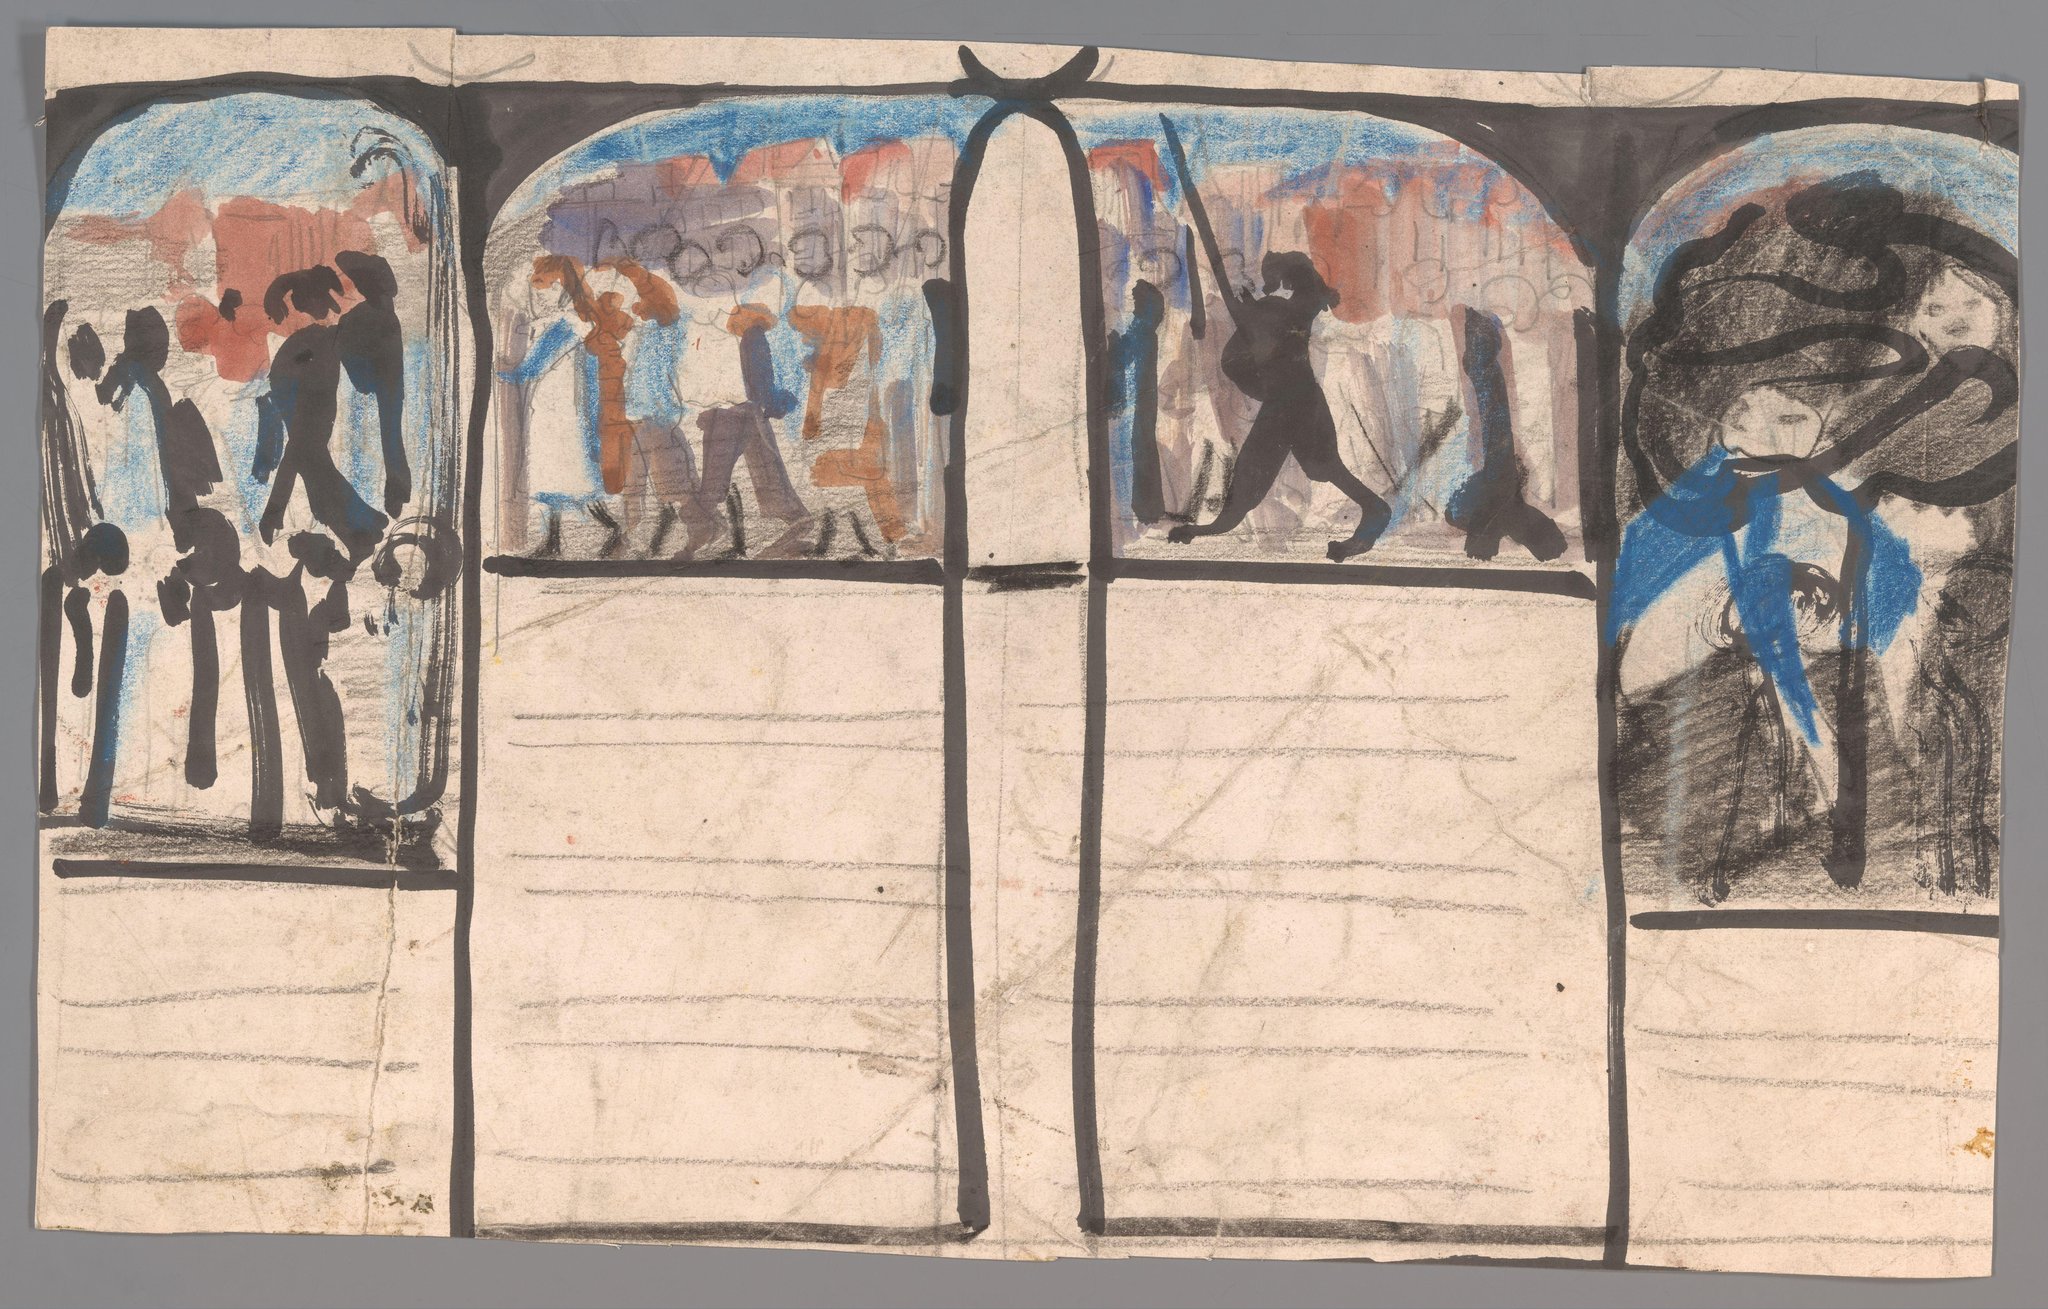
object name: drawing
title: Ontwerp met vier scènes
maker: carel adolph lion cachet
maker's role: draughtsman, print maker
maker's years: 1864-1945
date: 1874-1945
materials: chalk, paper, pencil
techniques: brush